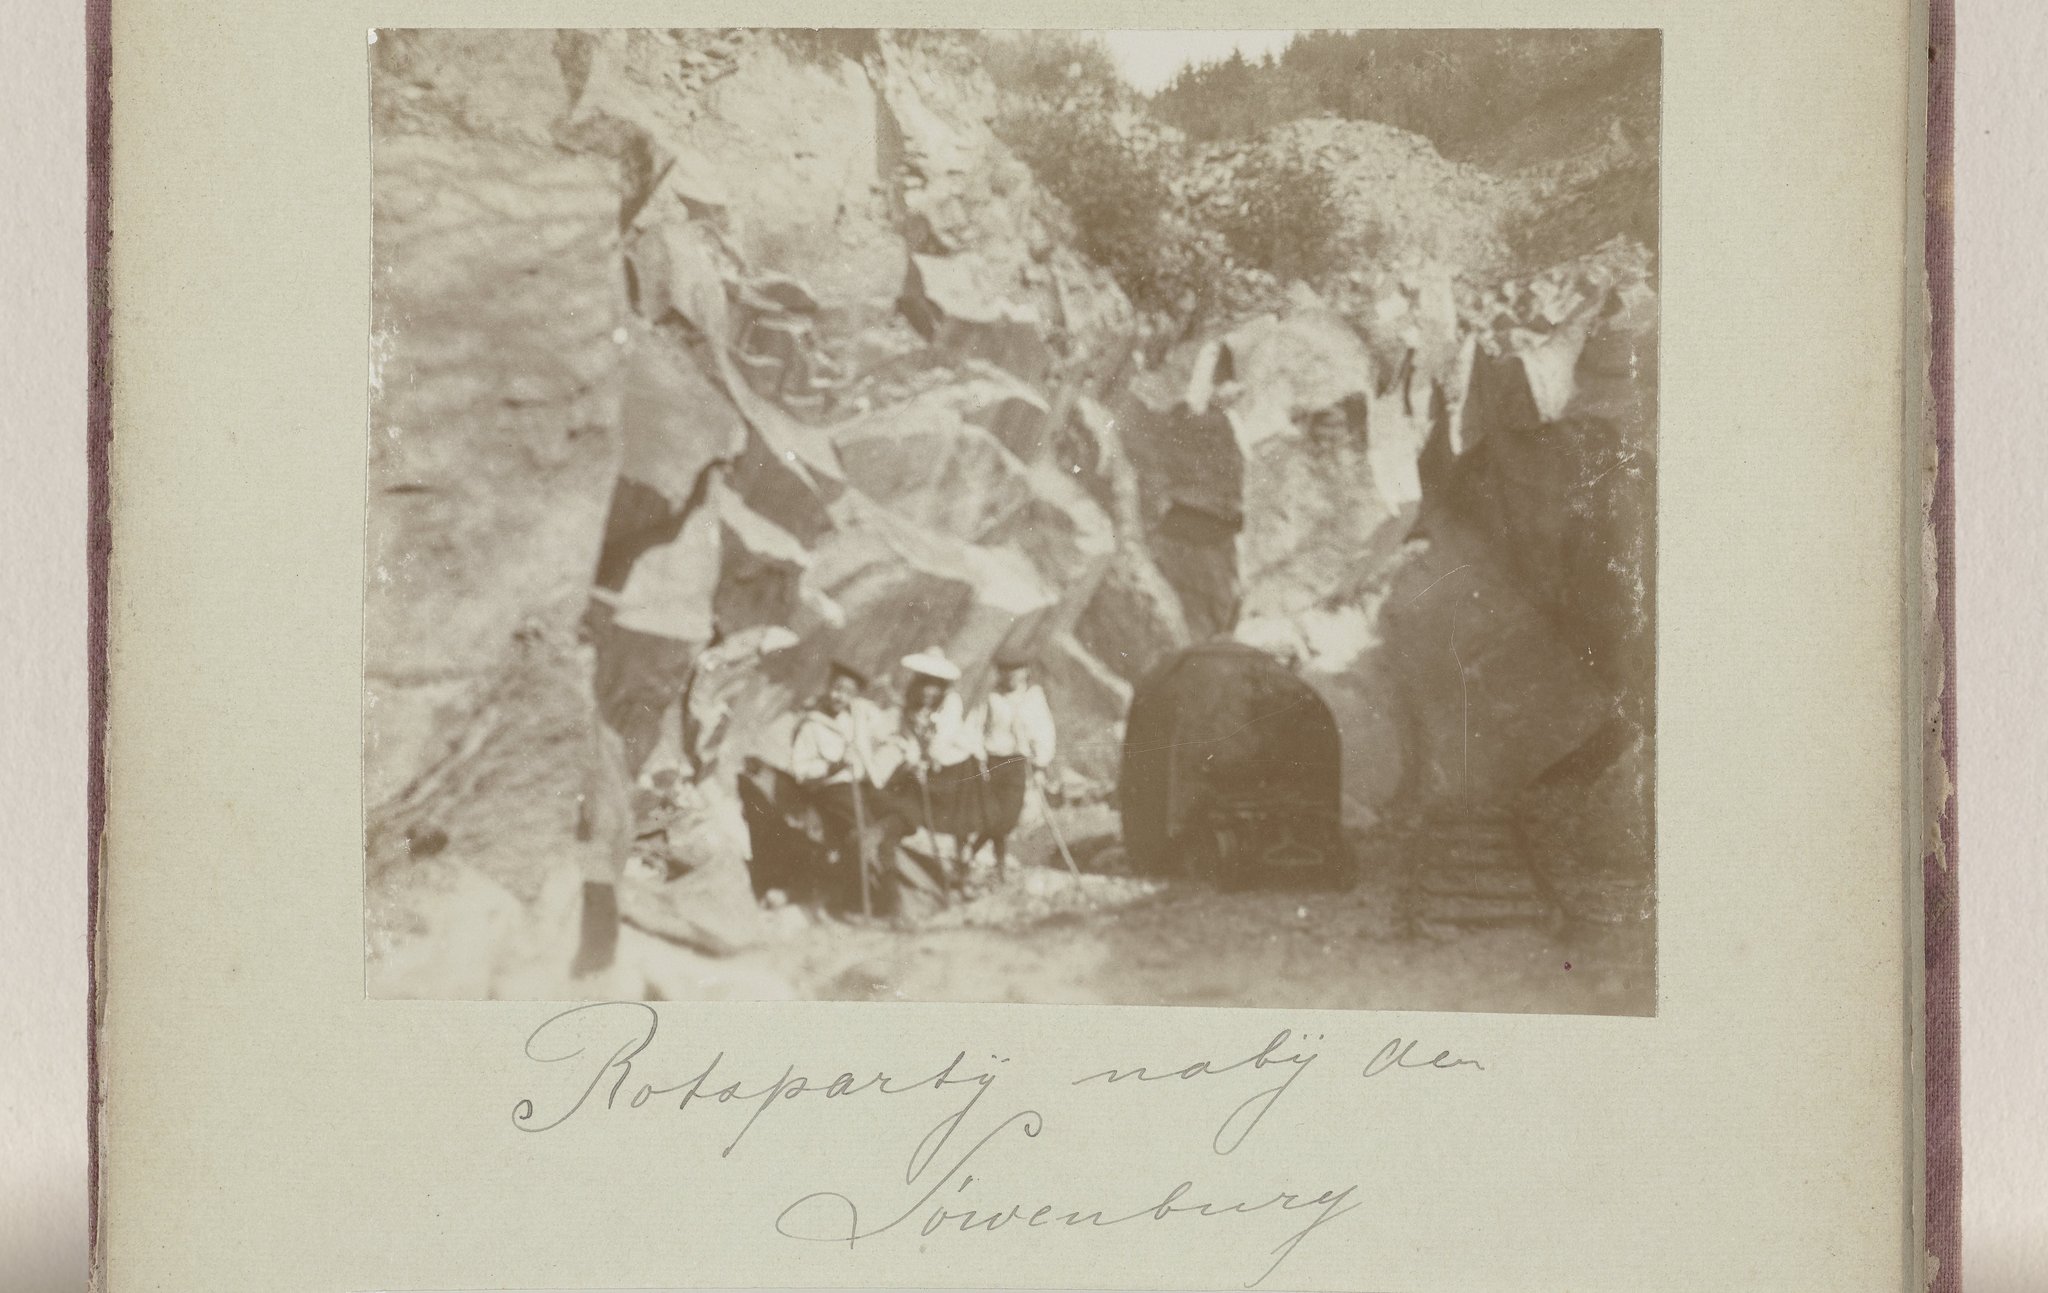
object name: photograph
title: Drie kinderen bij een rotspartij bij de Löwenburg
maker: david vermeulen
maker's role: fotograaf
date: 1895-1905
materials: paper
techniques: collodion silver print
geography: löwenburg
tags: rock-formations, child between toddler and youth (of undetermined sex)